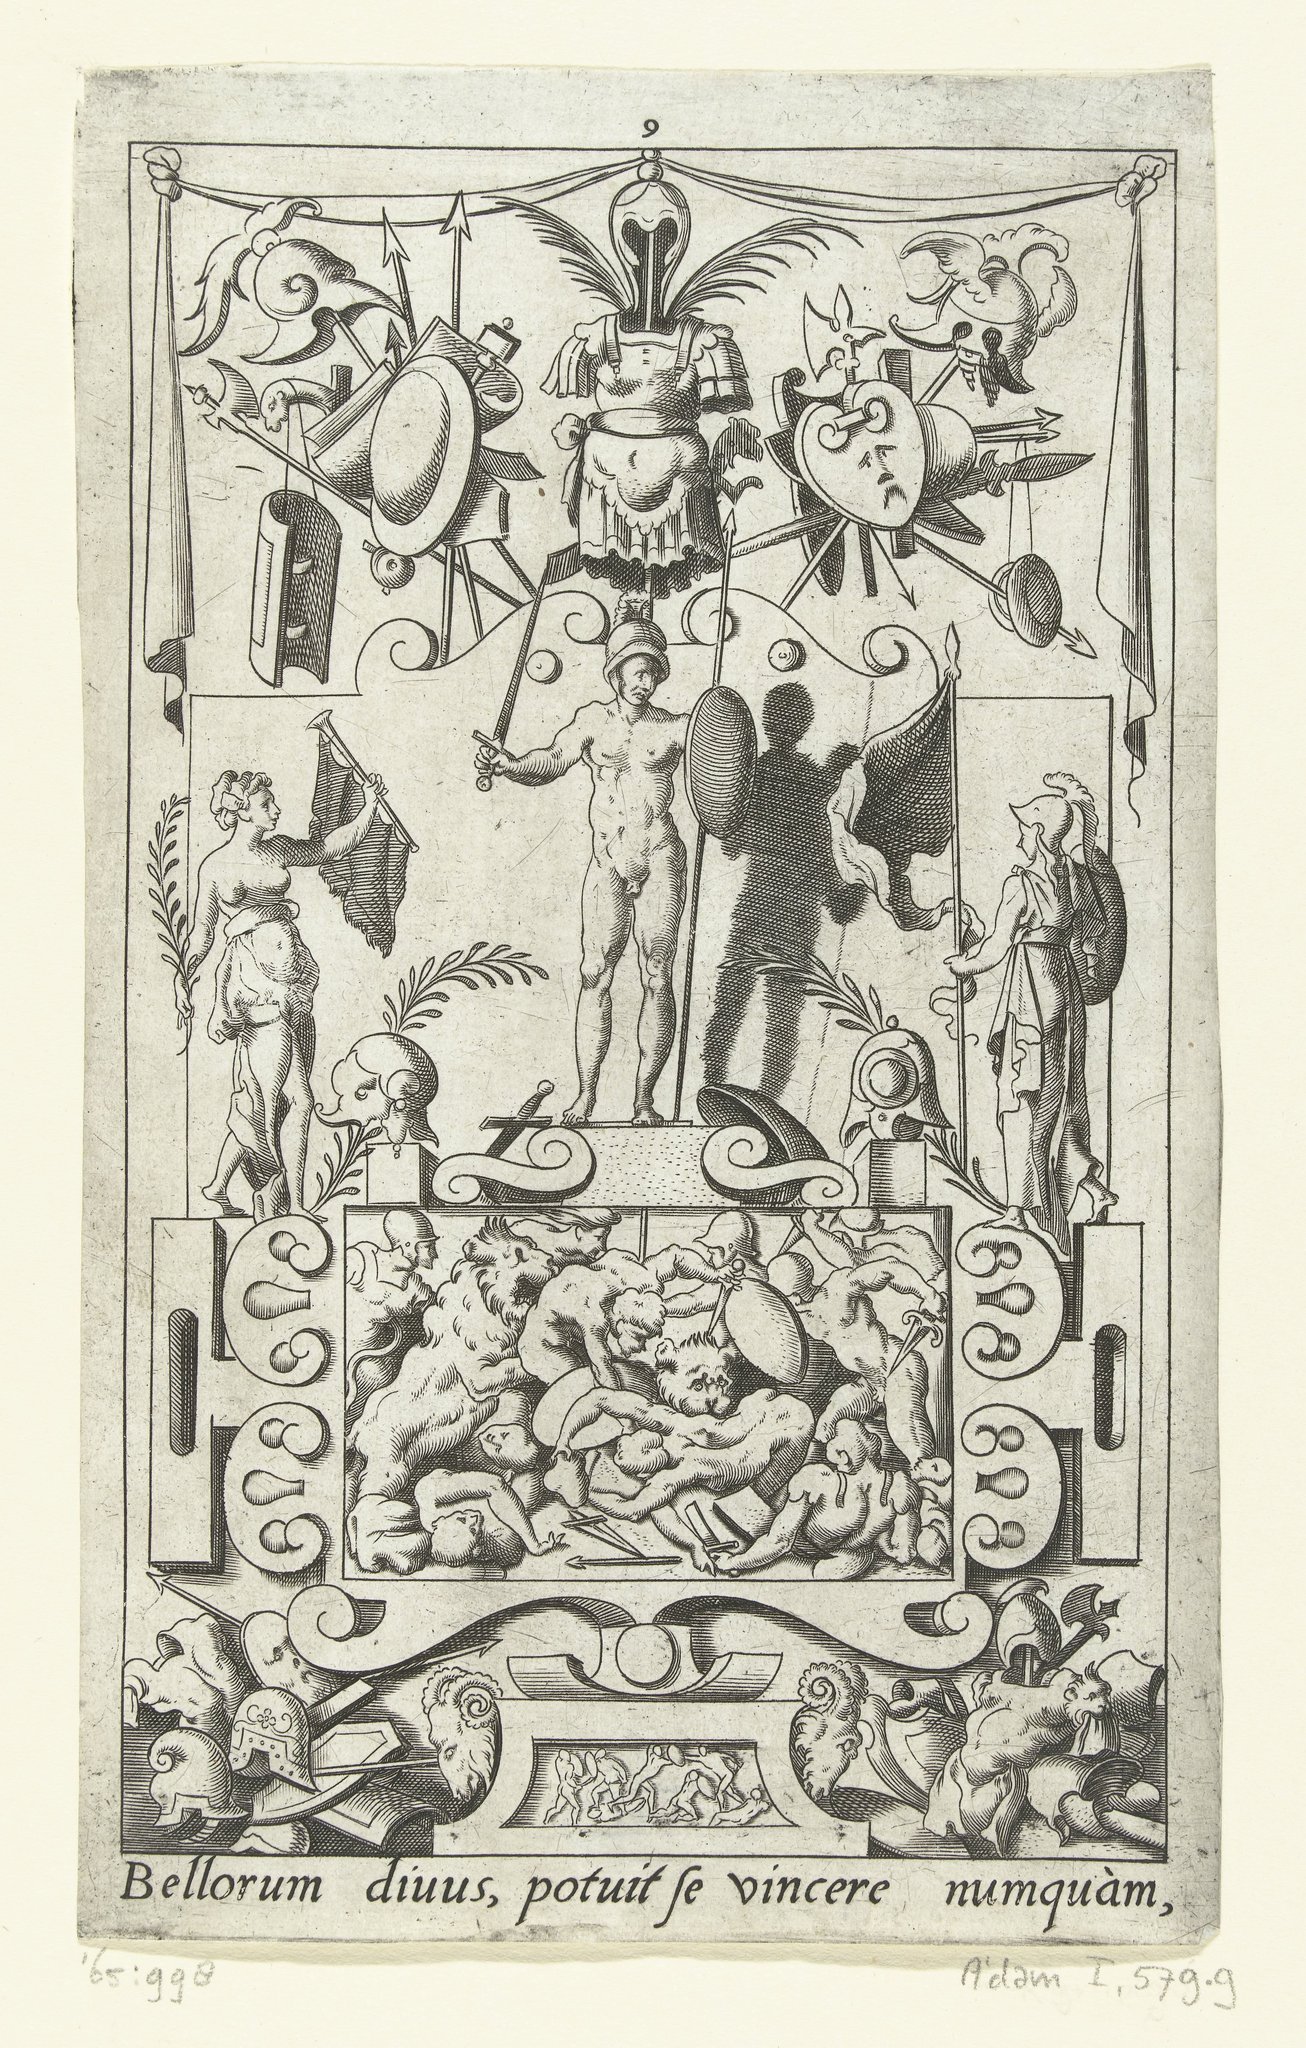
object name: print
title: Goden en godinnen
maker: rené boyvin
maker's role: print maker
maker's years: 1525-1598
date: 1551-1580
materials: paper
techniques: engraving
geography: france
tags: (story of) mars (ares)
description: Onderaan staat een Latijnse tekst. Uit serie van 16 deels genummerde bladen met vlakdecoraties van goden en godinnen in een omlijsting van grotesken met fantastische wezens, dieren, guirlandes en mascarons.